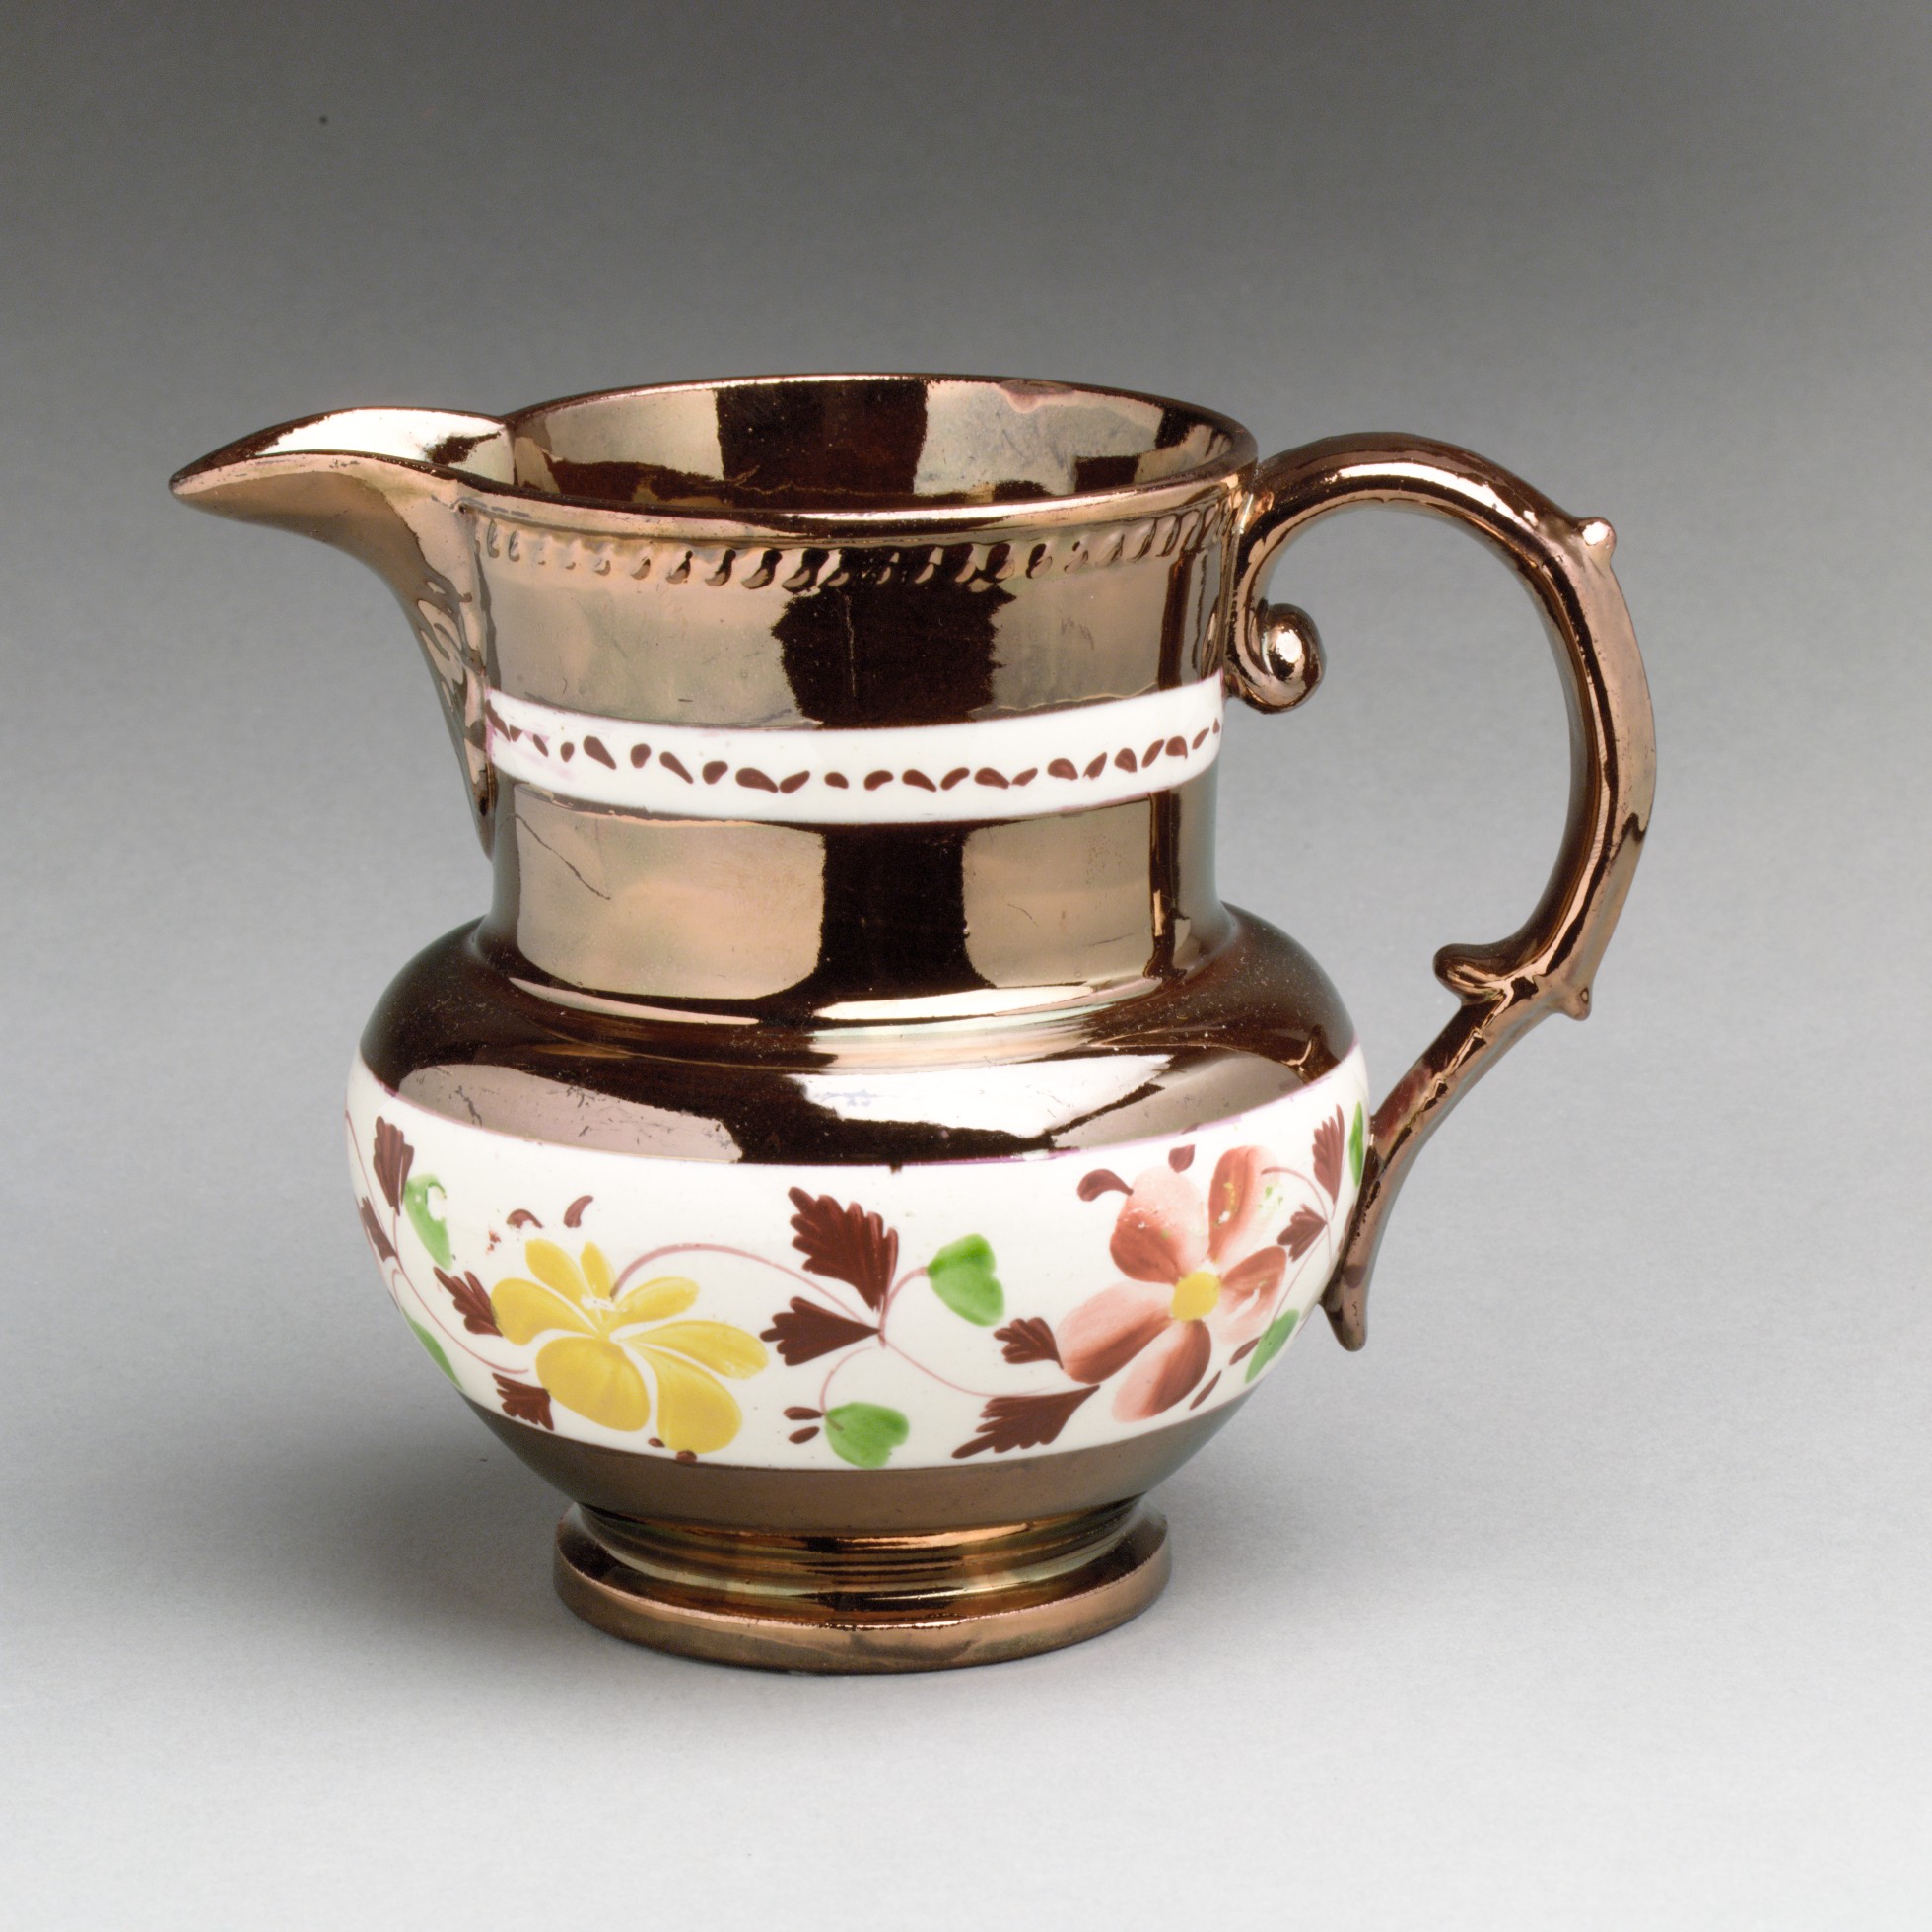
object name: pitcher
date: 1801-1900